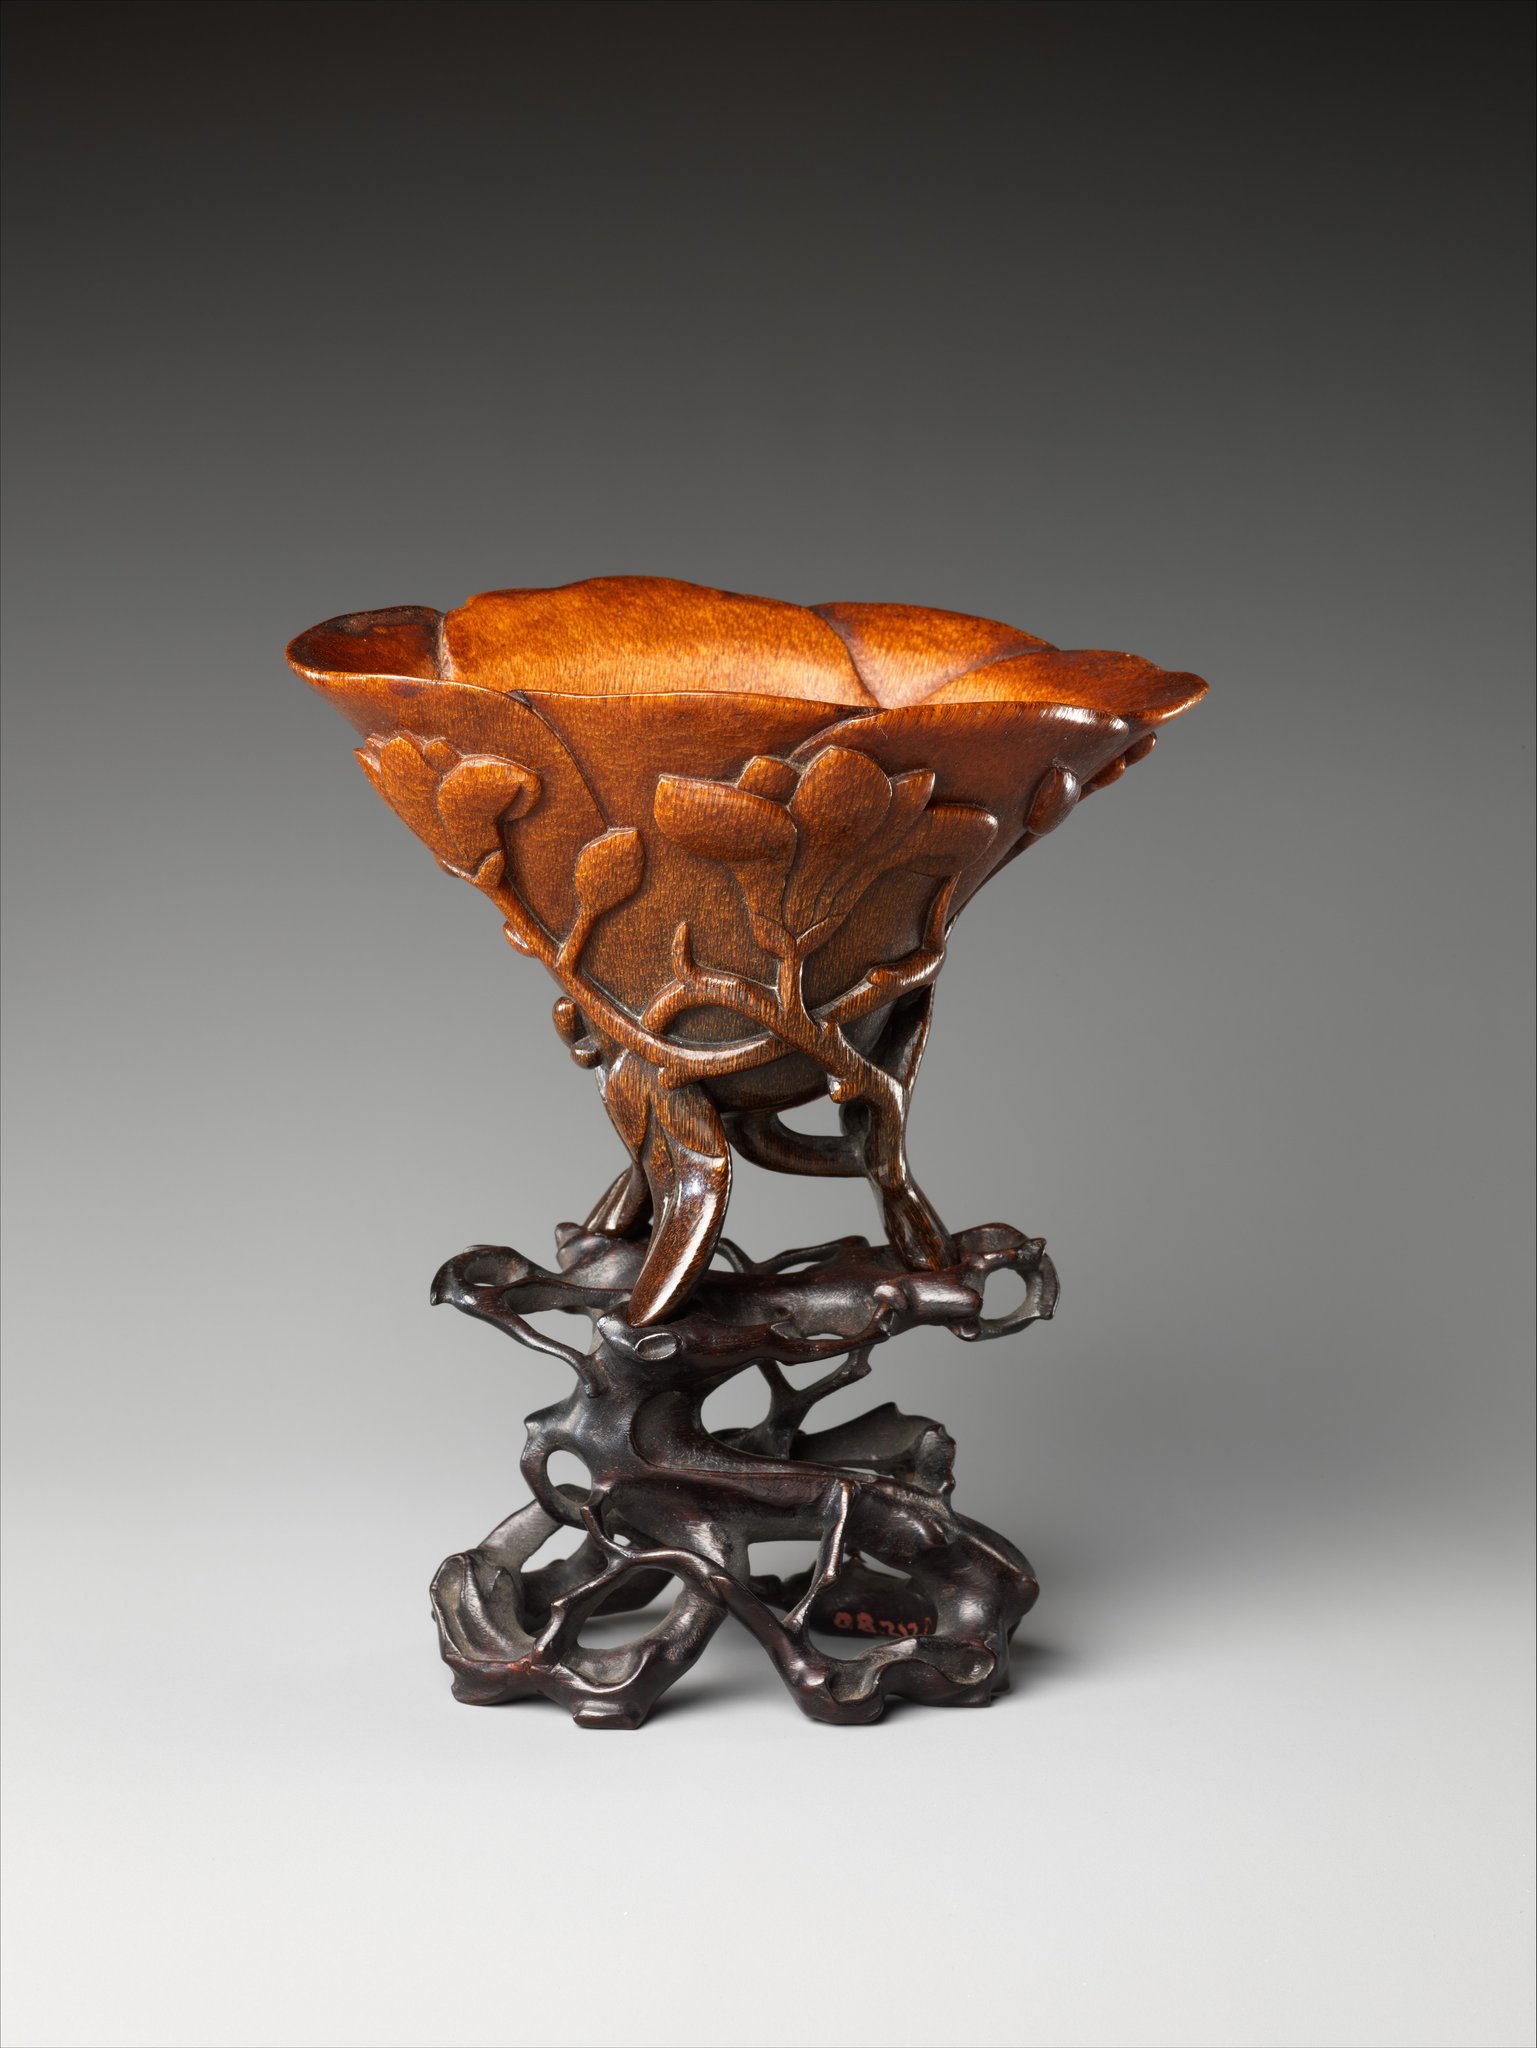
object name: cup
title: Cup in the shape of a magnolia blossom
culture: chinese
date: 1601-1633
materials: horn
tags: flowers